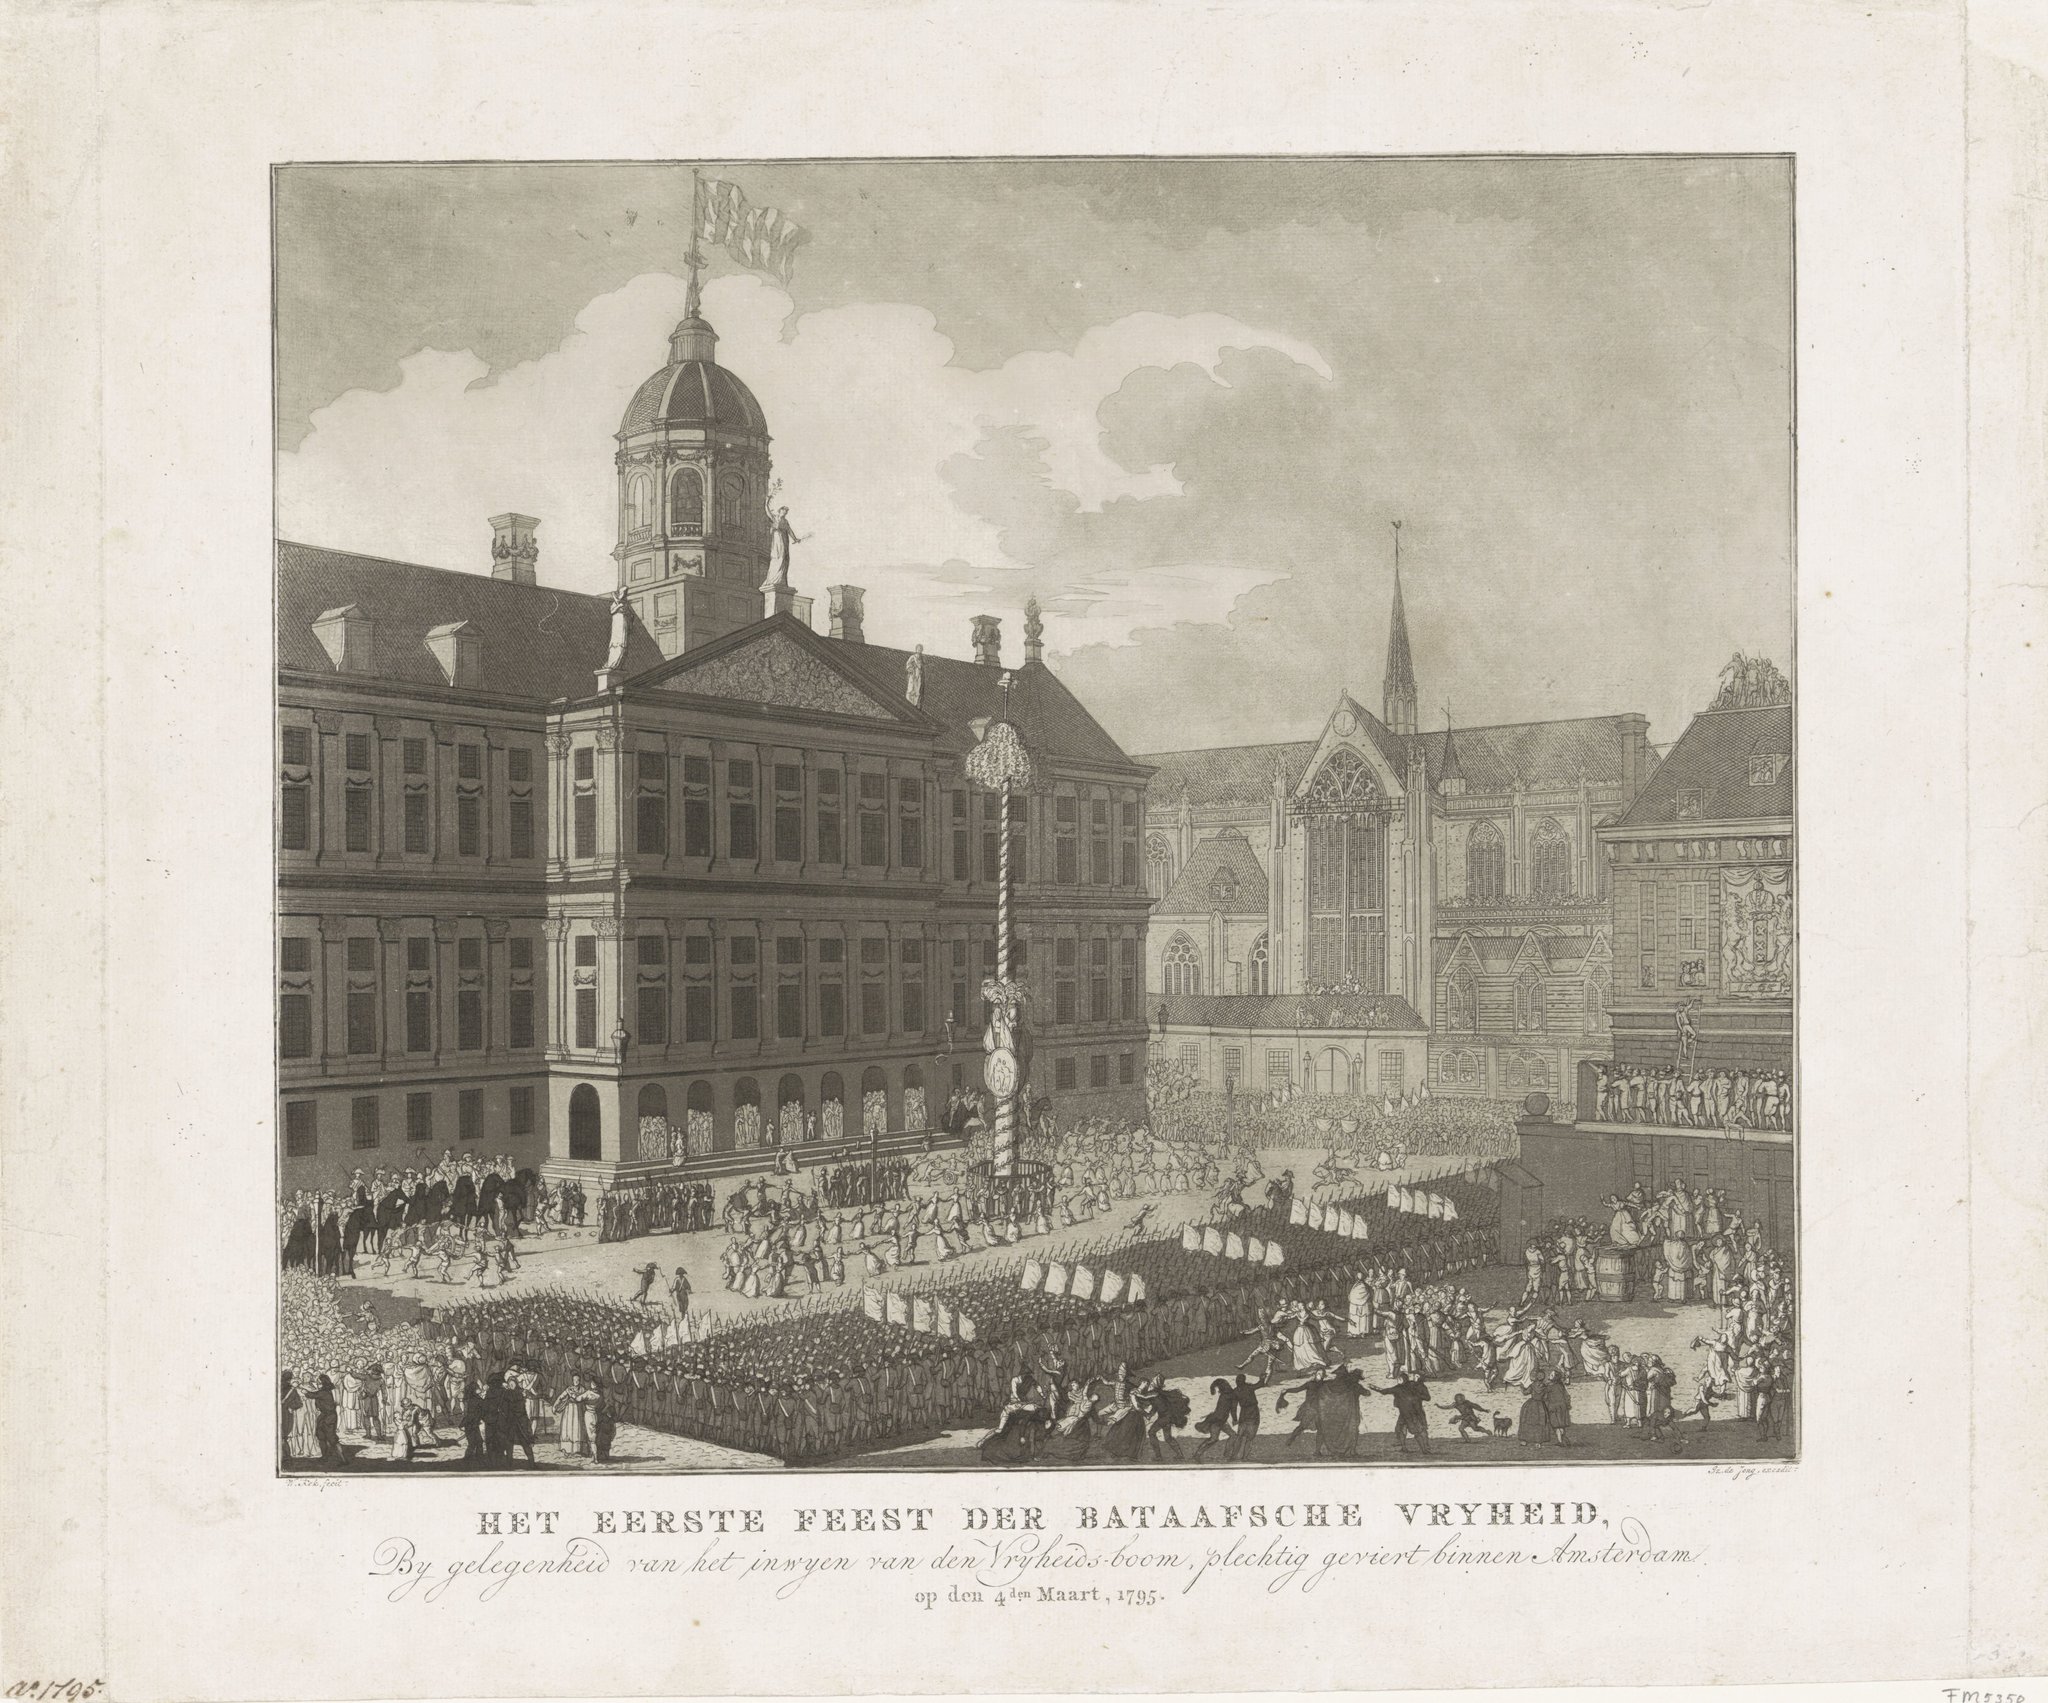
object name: print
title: Het Eerste Feest der Bataafsche Vryheid, By gelegenheid van het inwyden van den Vrijheids-boom, plechtig geviert binnen Amsterdam op den 4.den Maart 1795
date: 1795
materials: paper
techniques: aquatint, etching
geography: amsterdam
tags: dancing around the tree of liberty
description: Feest der Vrijheid, gevierd bij de inwijding van de vrijheidsboom op de Dam te Amsterdam, 4 maart 1795. Gezicht van bovenaf op de Dam waar een slinger van mensen danst om de vrijheidsboom, het plein is afgezet door militairen.